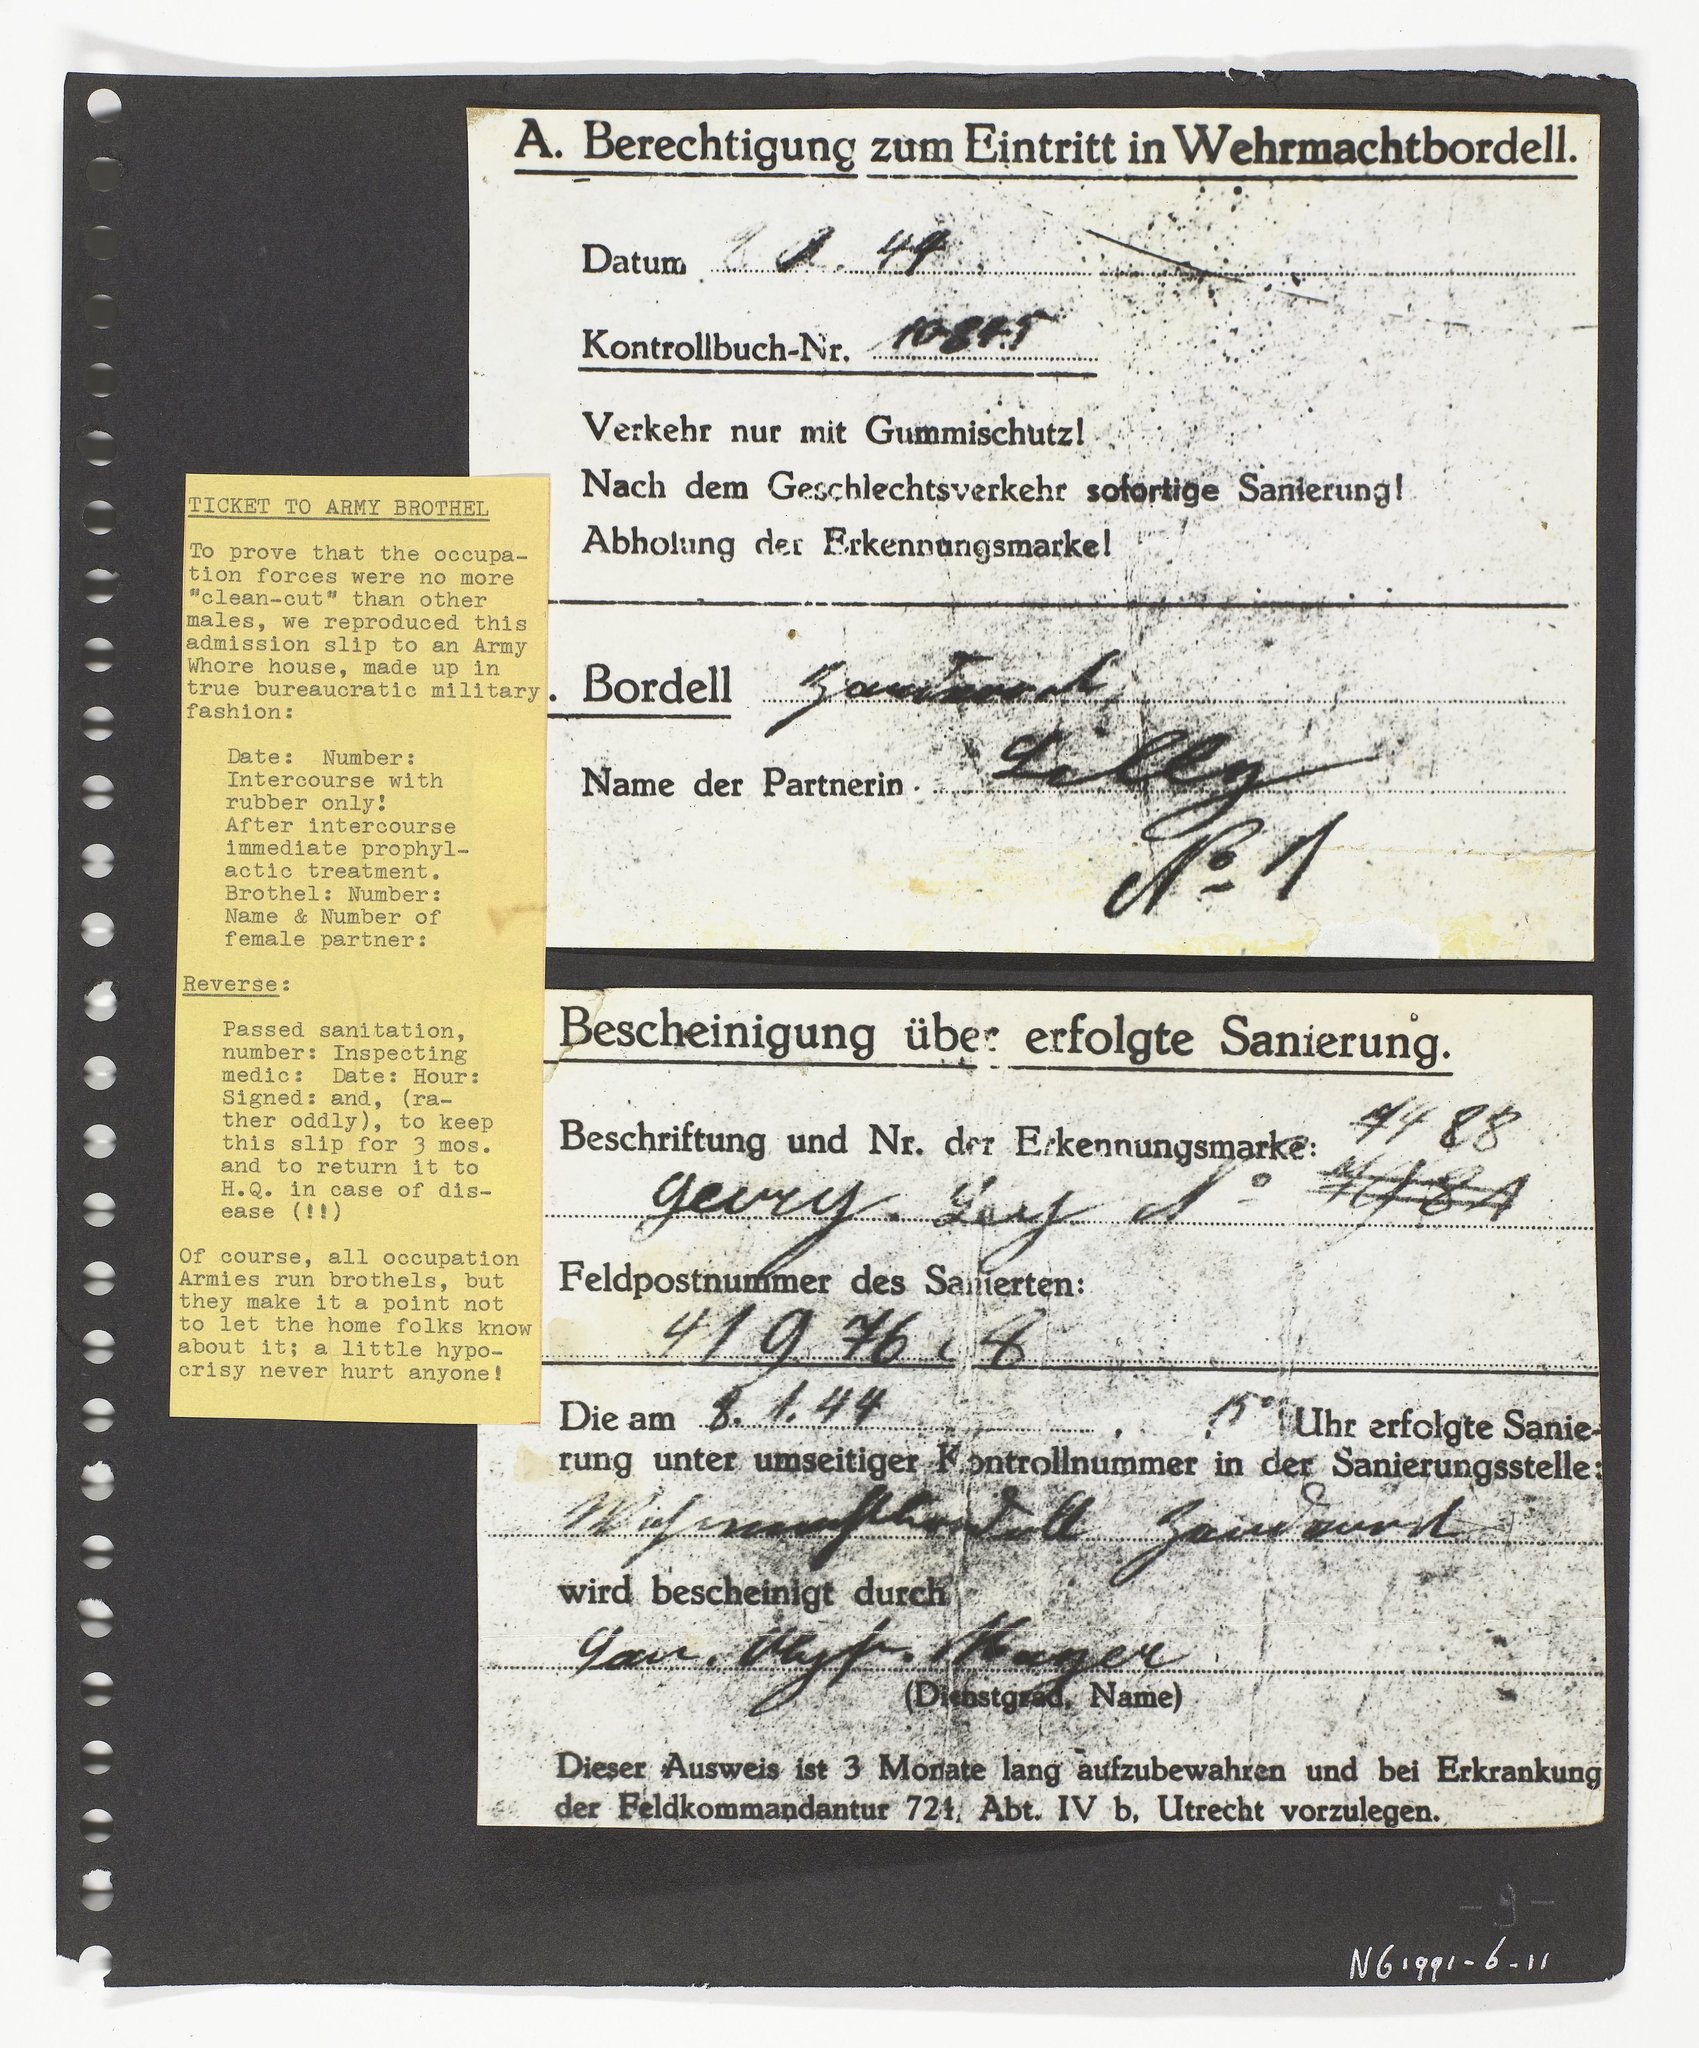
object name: photograph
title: Formulieren voor bordeelbezoek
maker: Anonymous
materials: paper, plastic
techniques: photography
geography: netherlands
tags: amsterdam, tonny van renterghem, berlin, fritz kahlenberg, brothel, occupation ~ war, netherlands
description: Kopieën van de voor- en achterkant van een formulier voor een bordeelbezoek voor soldaten van de Wehrmacht.